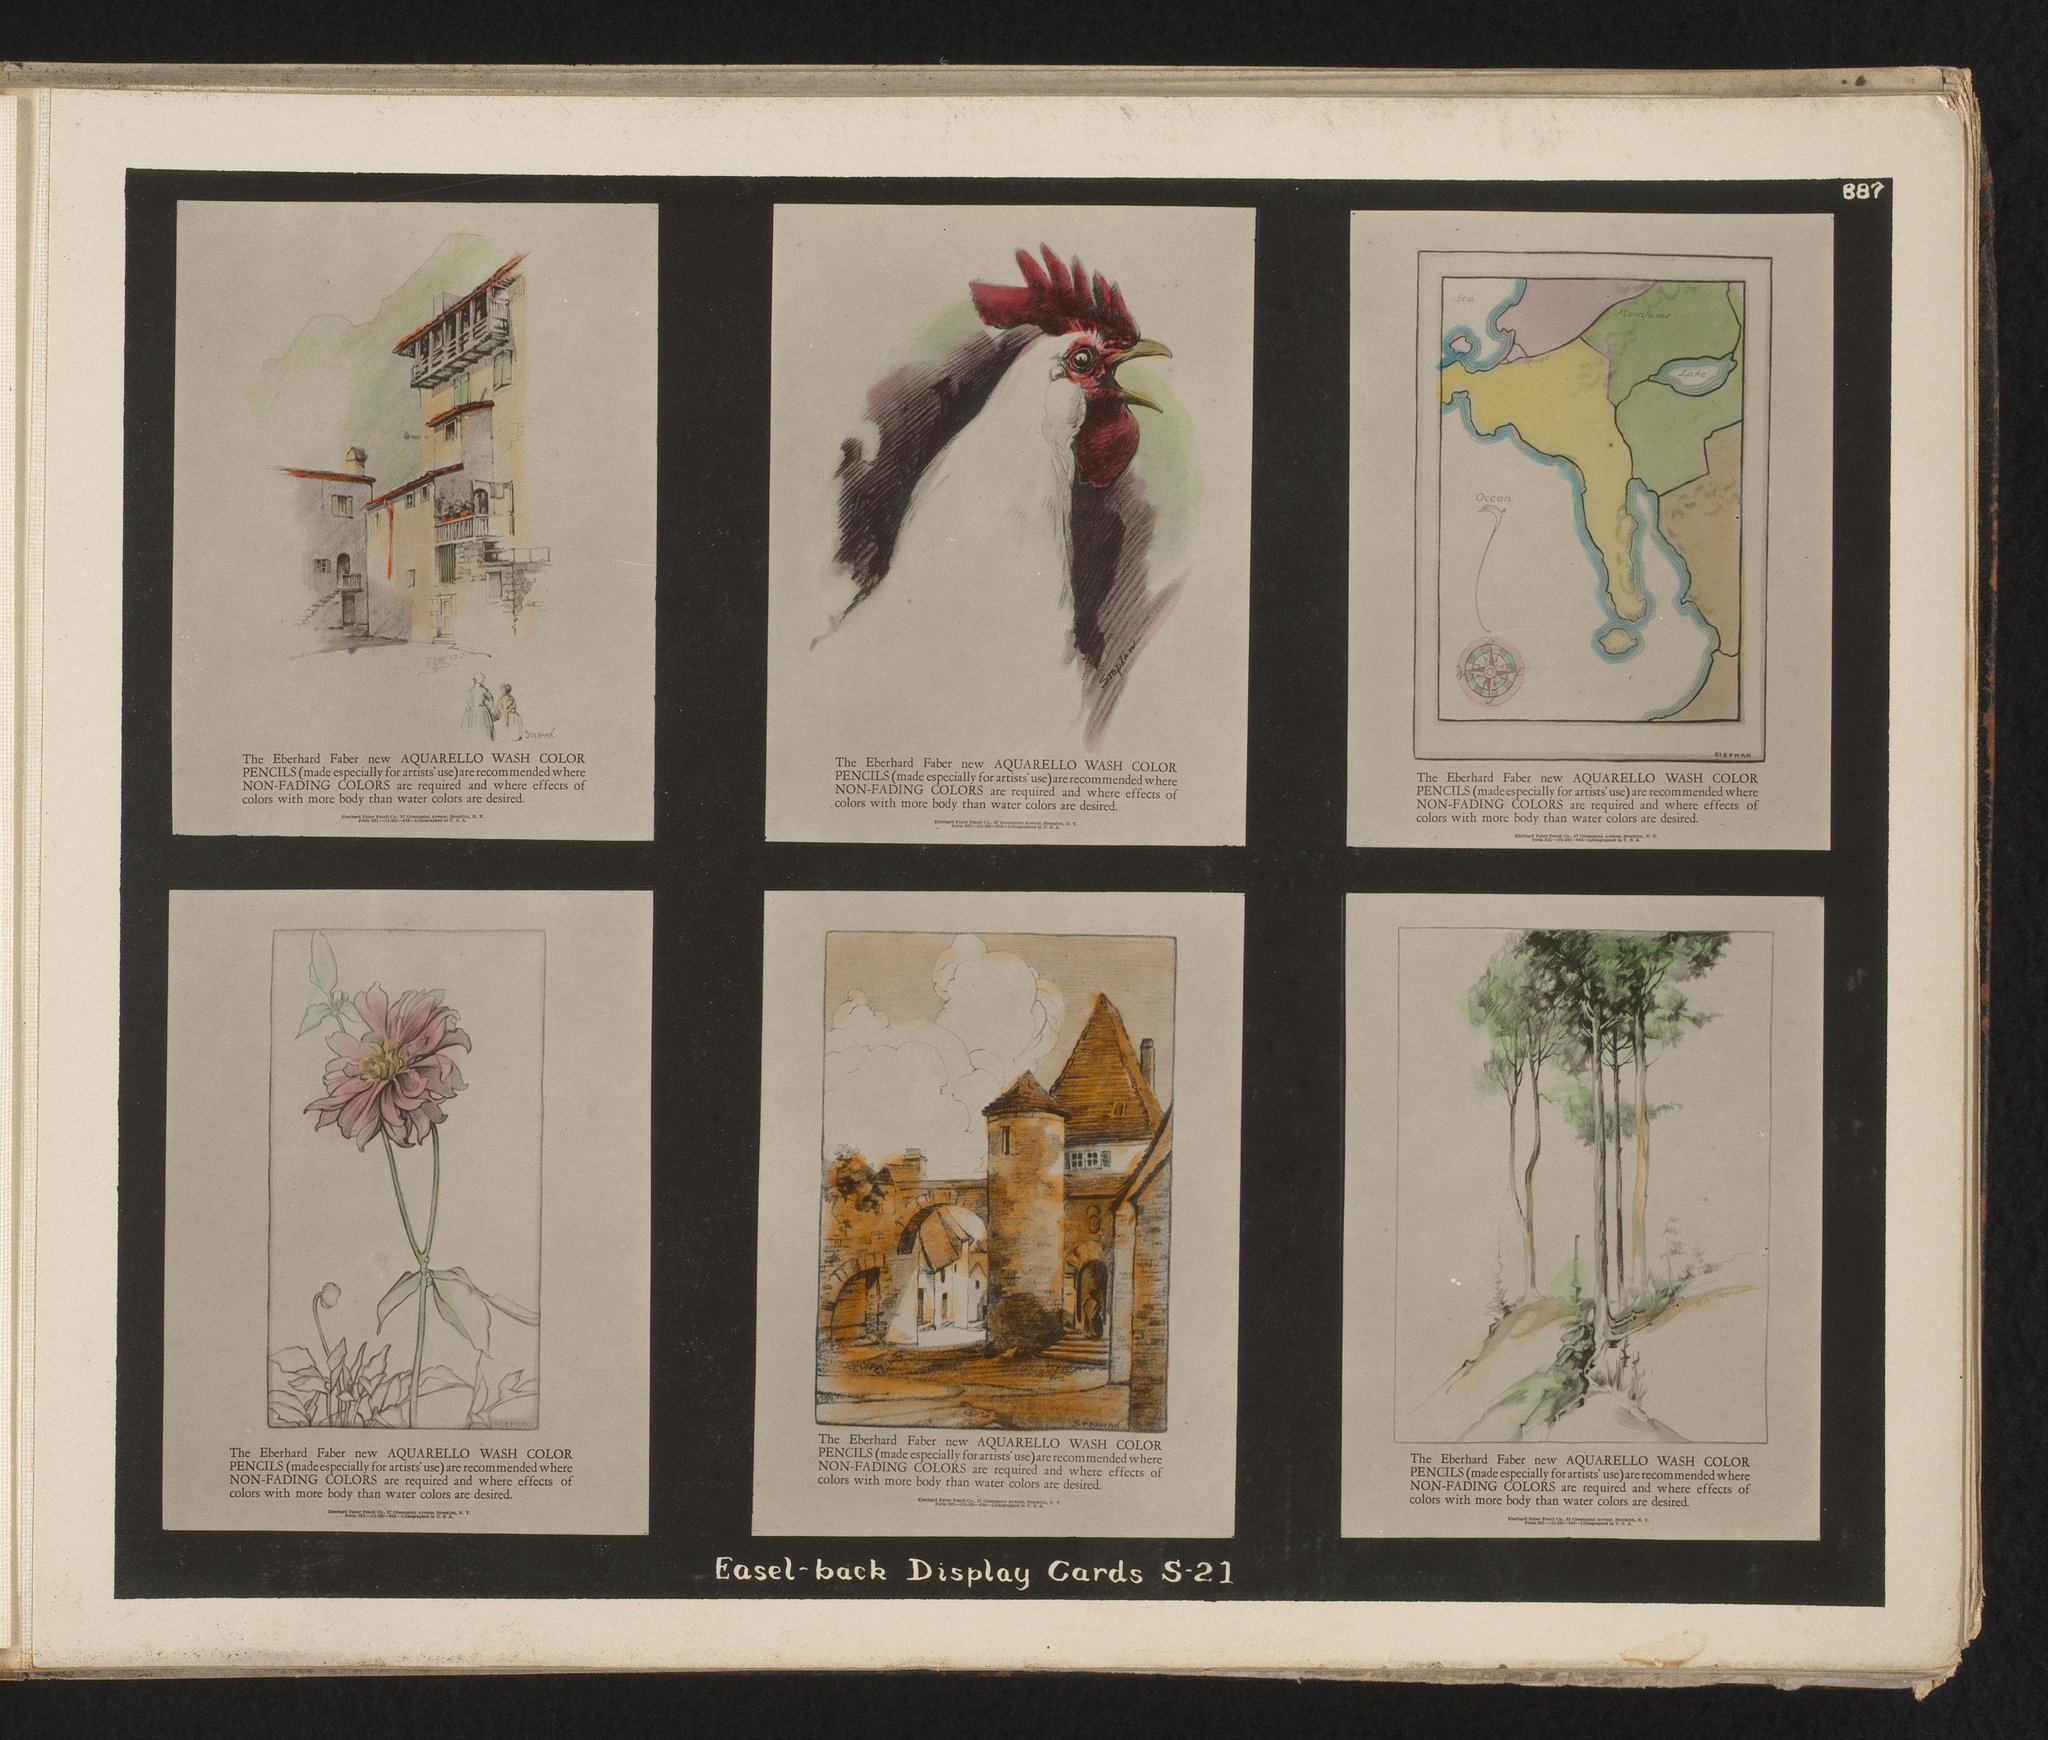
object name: photograph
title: Reclame voor aquarelpotloden van Eberhard Faber met zes voorbeelden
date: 1915-1935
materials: paper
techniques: gelatin silver print, hand coloring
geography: springfield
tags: pencil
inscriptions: stamp: ‘Paramount/ Commercial Studios/ 145 Chestnut St./ Springfield - Mass.’, number: ‘887’